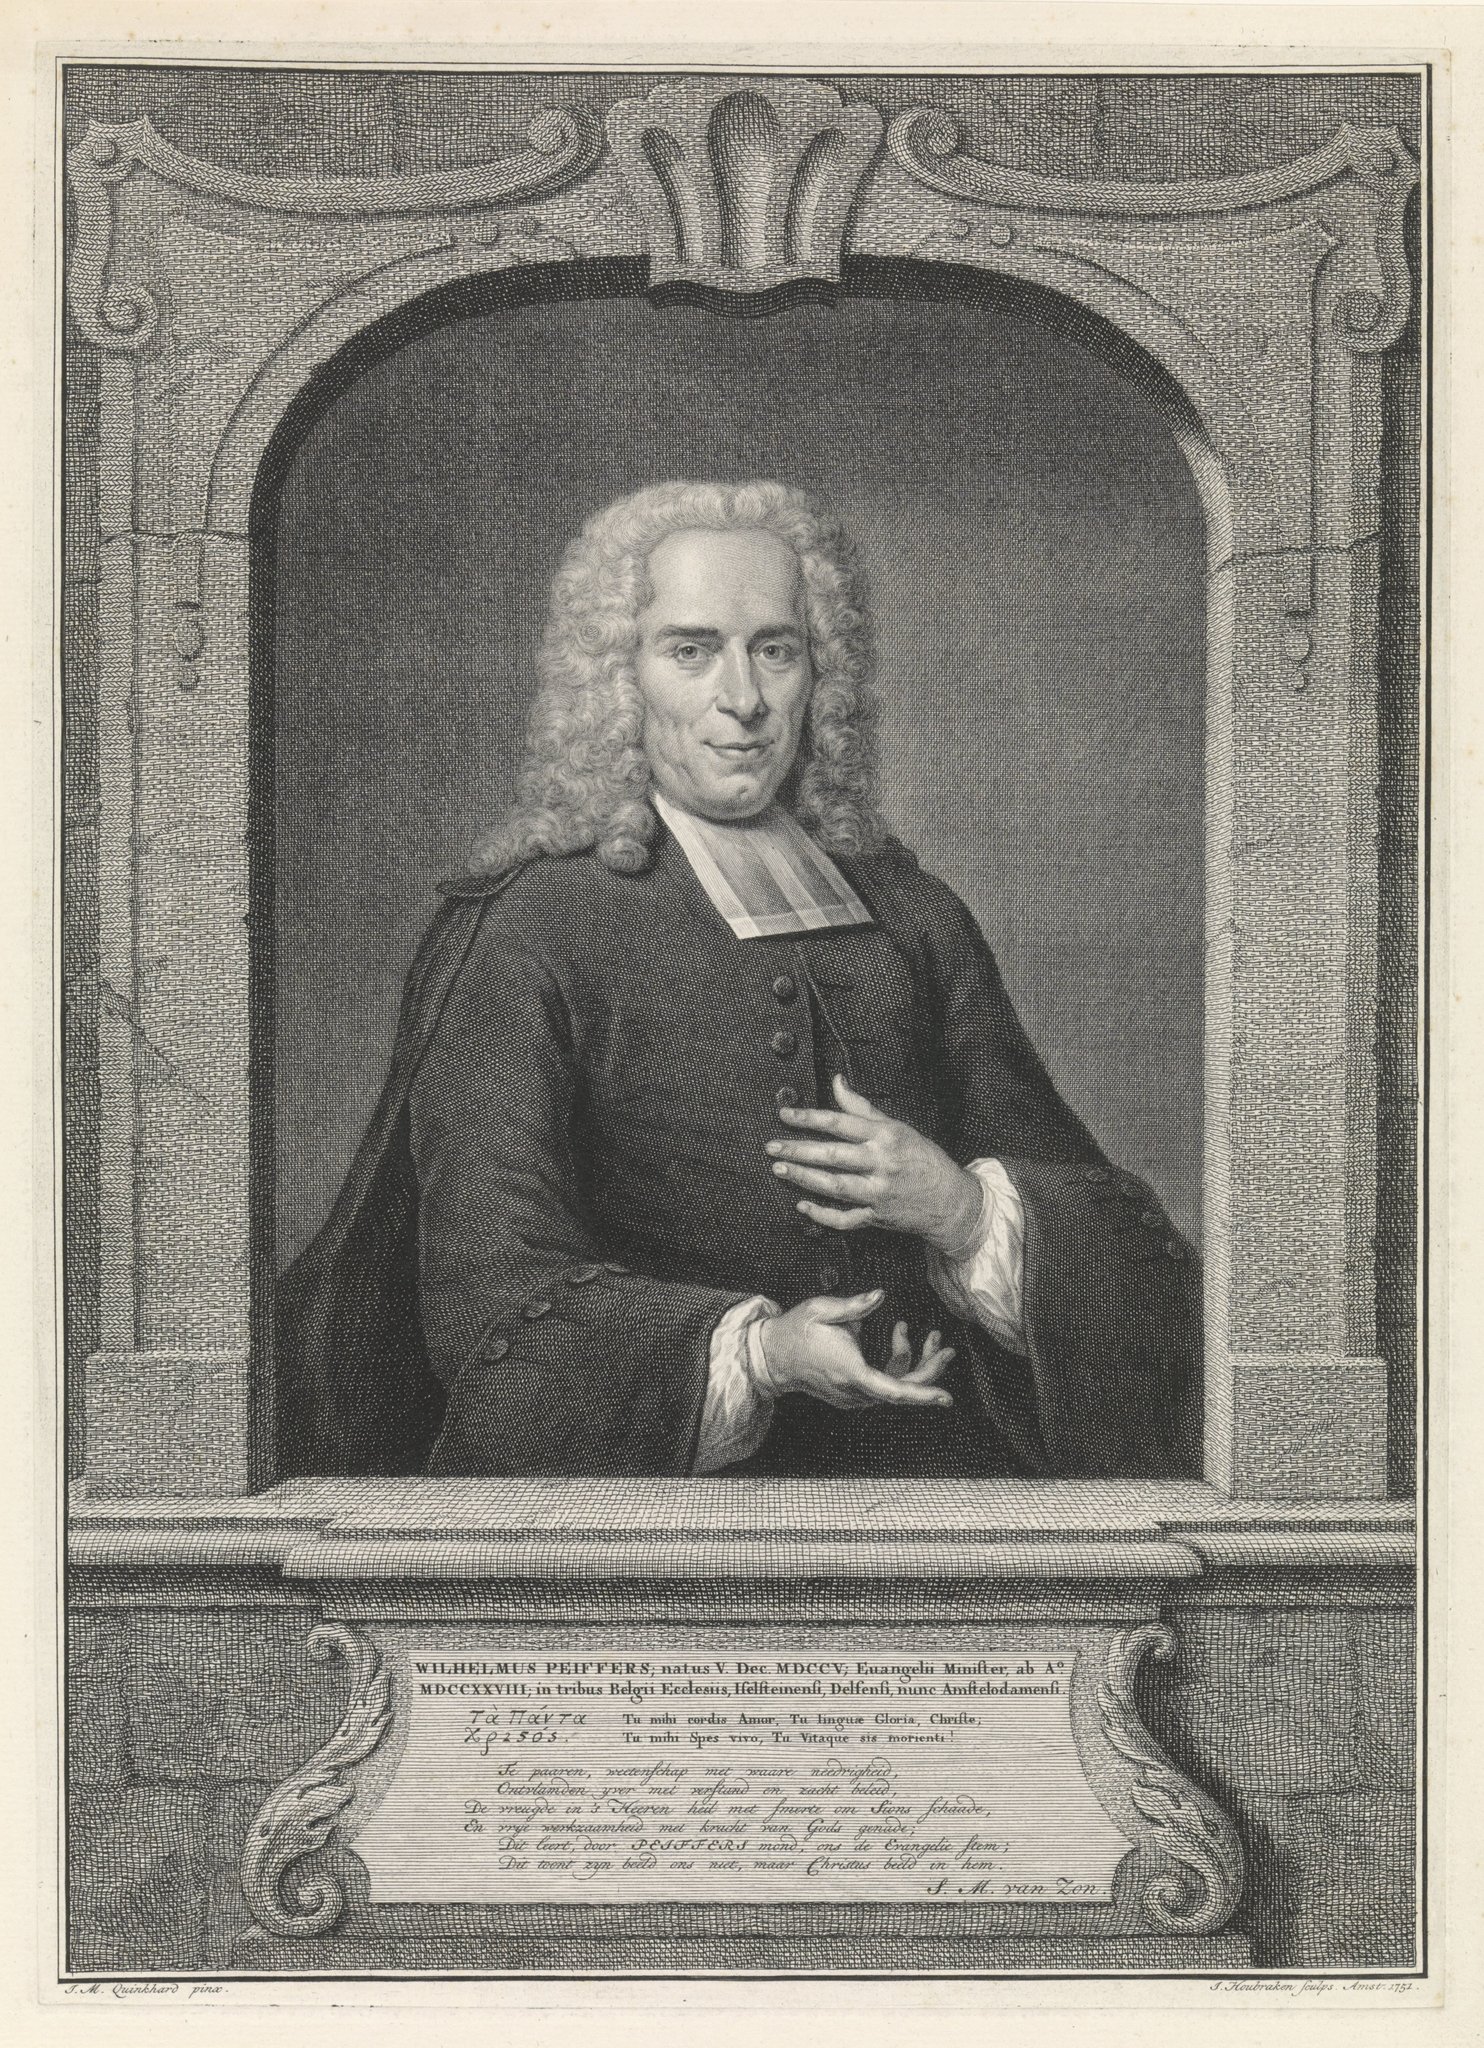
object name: print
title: Portret van Wilhelmus Peiffers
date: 1751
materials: paper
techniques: engraving, etching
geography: amsterdam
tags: historical persons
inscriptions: collector's mark: Lugt 240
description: Portret ten halven lijve van Wilhelmus Peiffers in een architectonisch venster. Onder de vensterbank zijn naam en gegevens in twee regels in het Latijn, daaronder links twee regels in het Hebreeuws en rechts twee regels in het Latijn. Daaronder een zesregelig vers in het Nederlands.